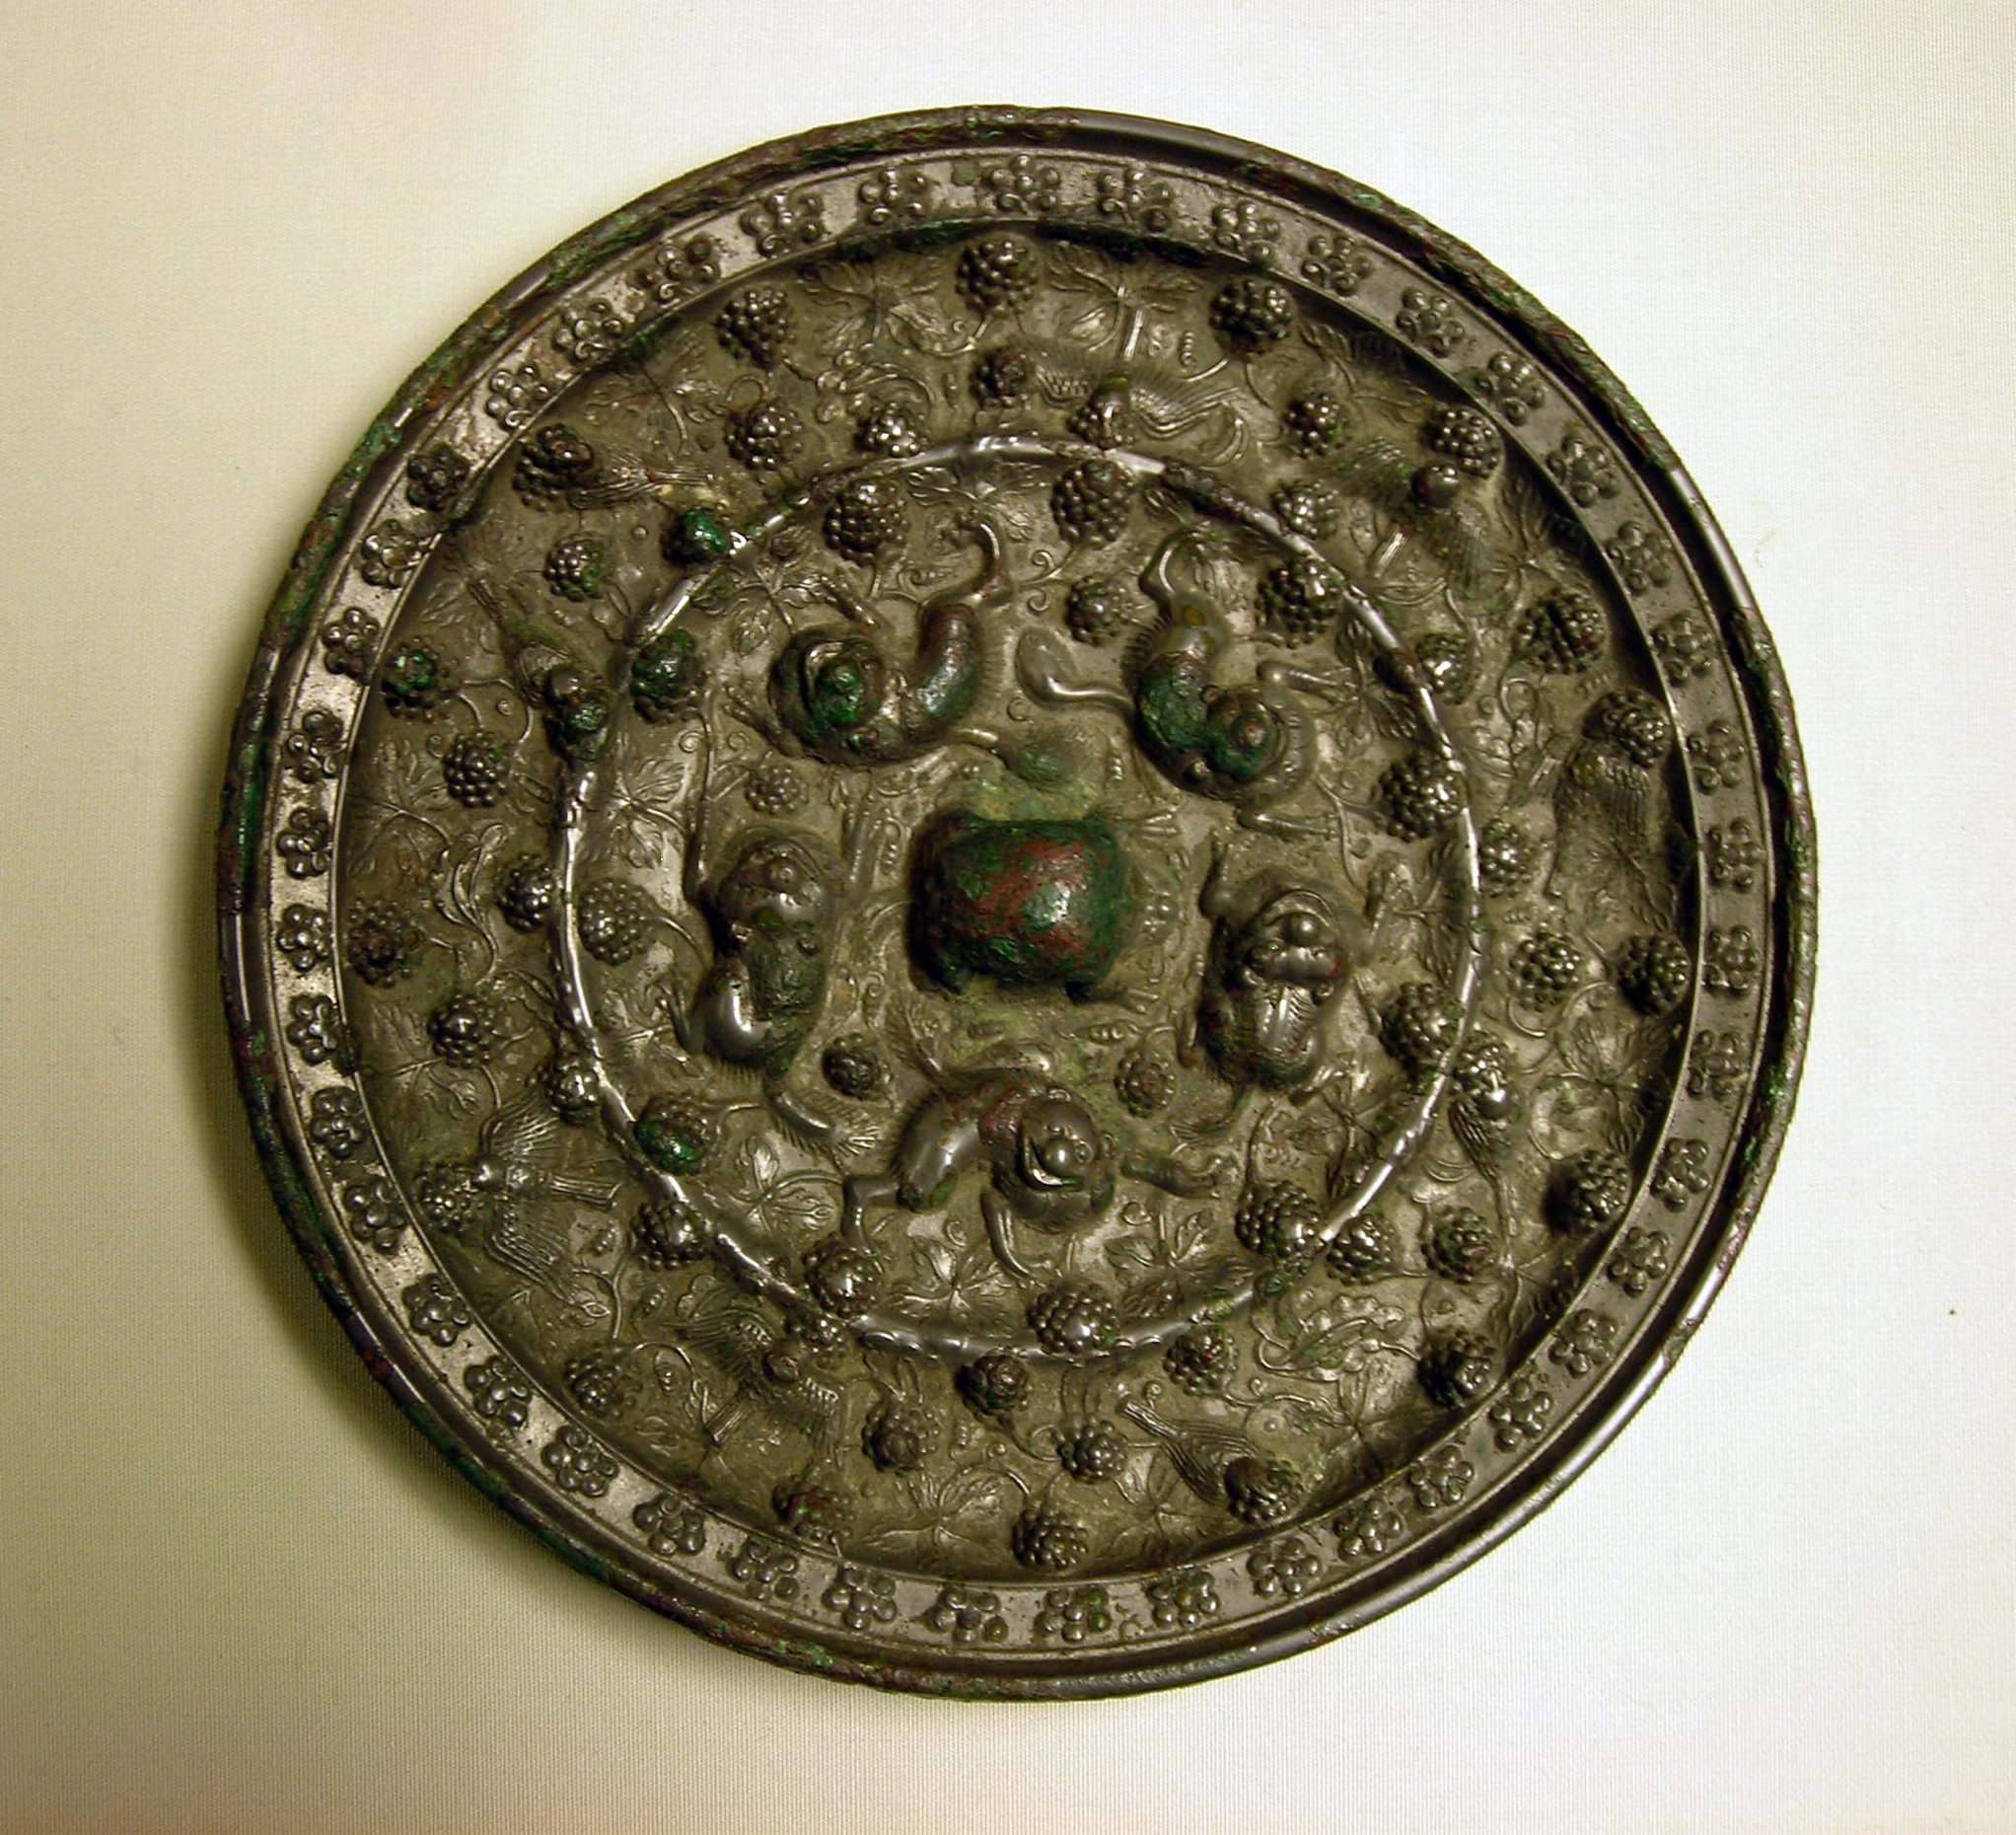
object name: mirror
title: Mirror with fantastic animals amid grape vines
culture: chinese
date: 601-800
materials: bronze, patina, silver